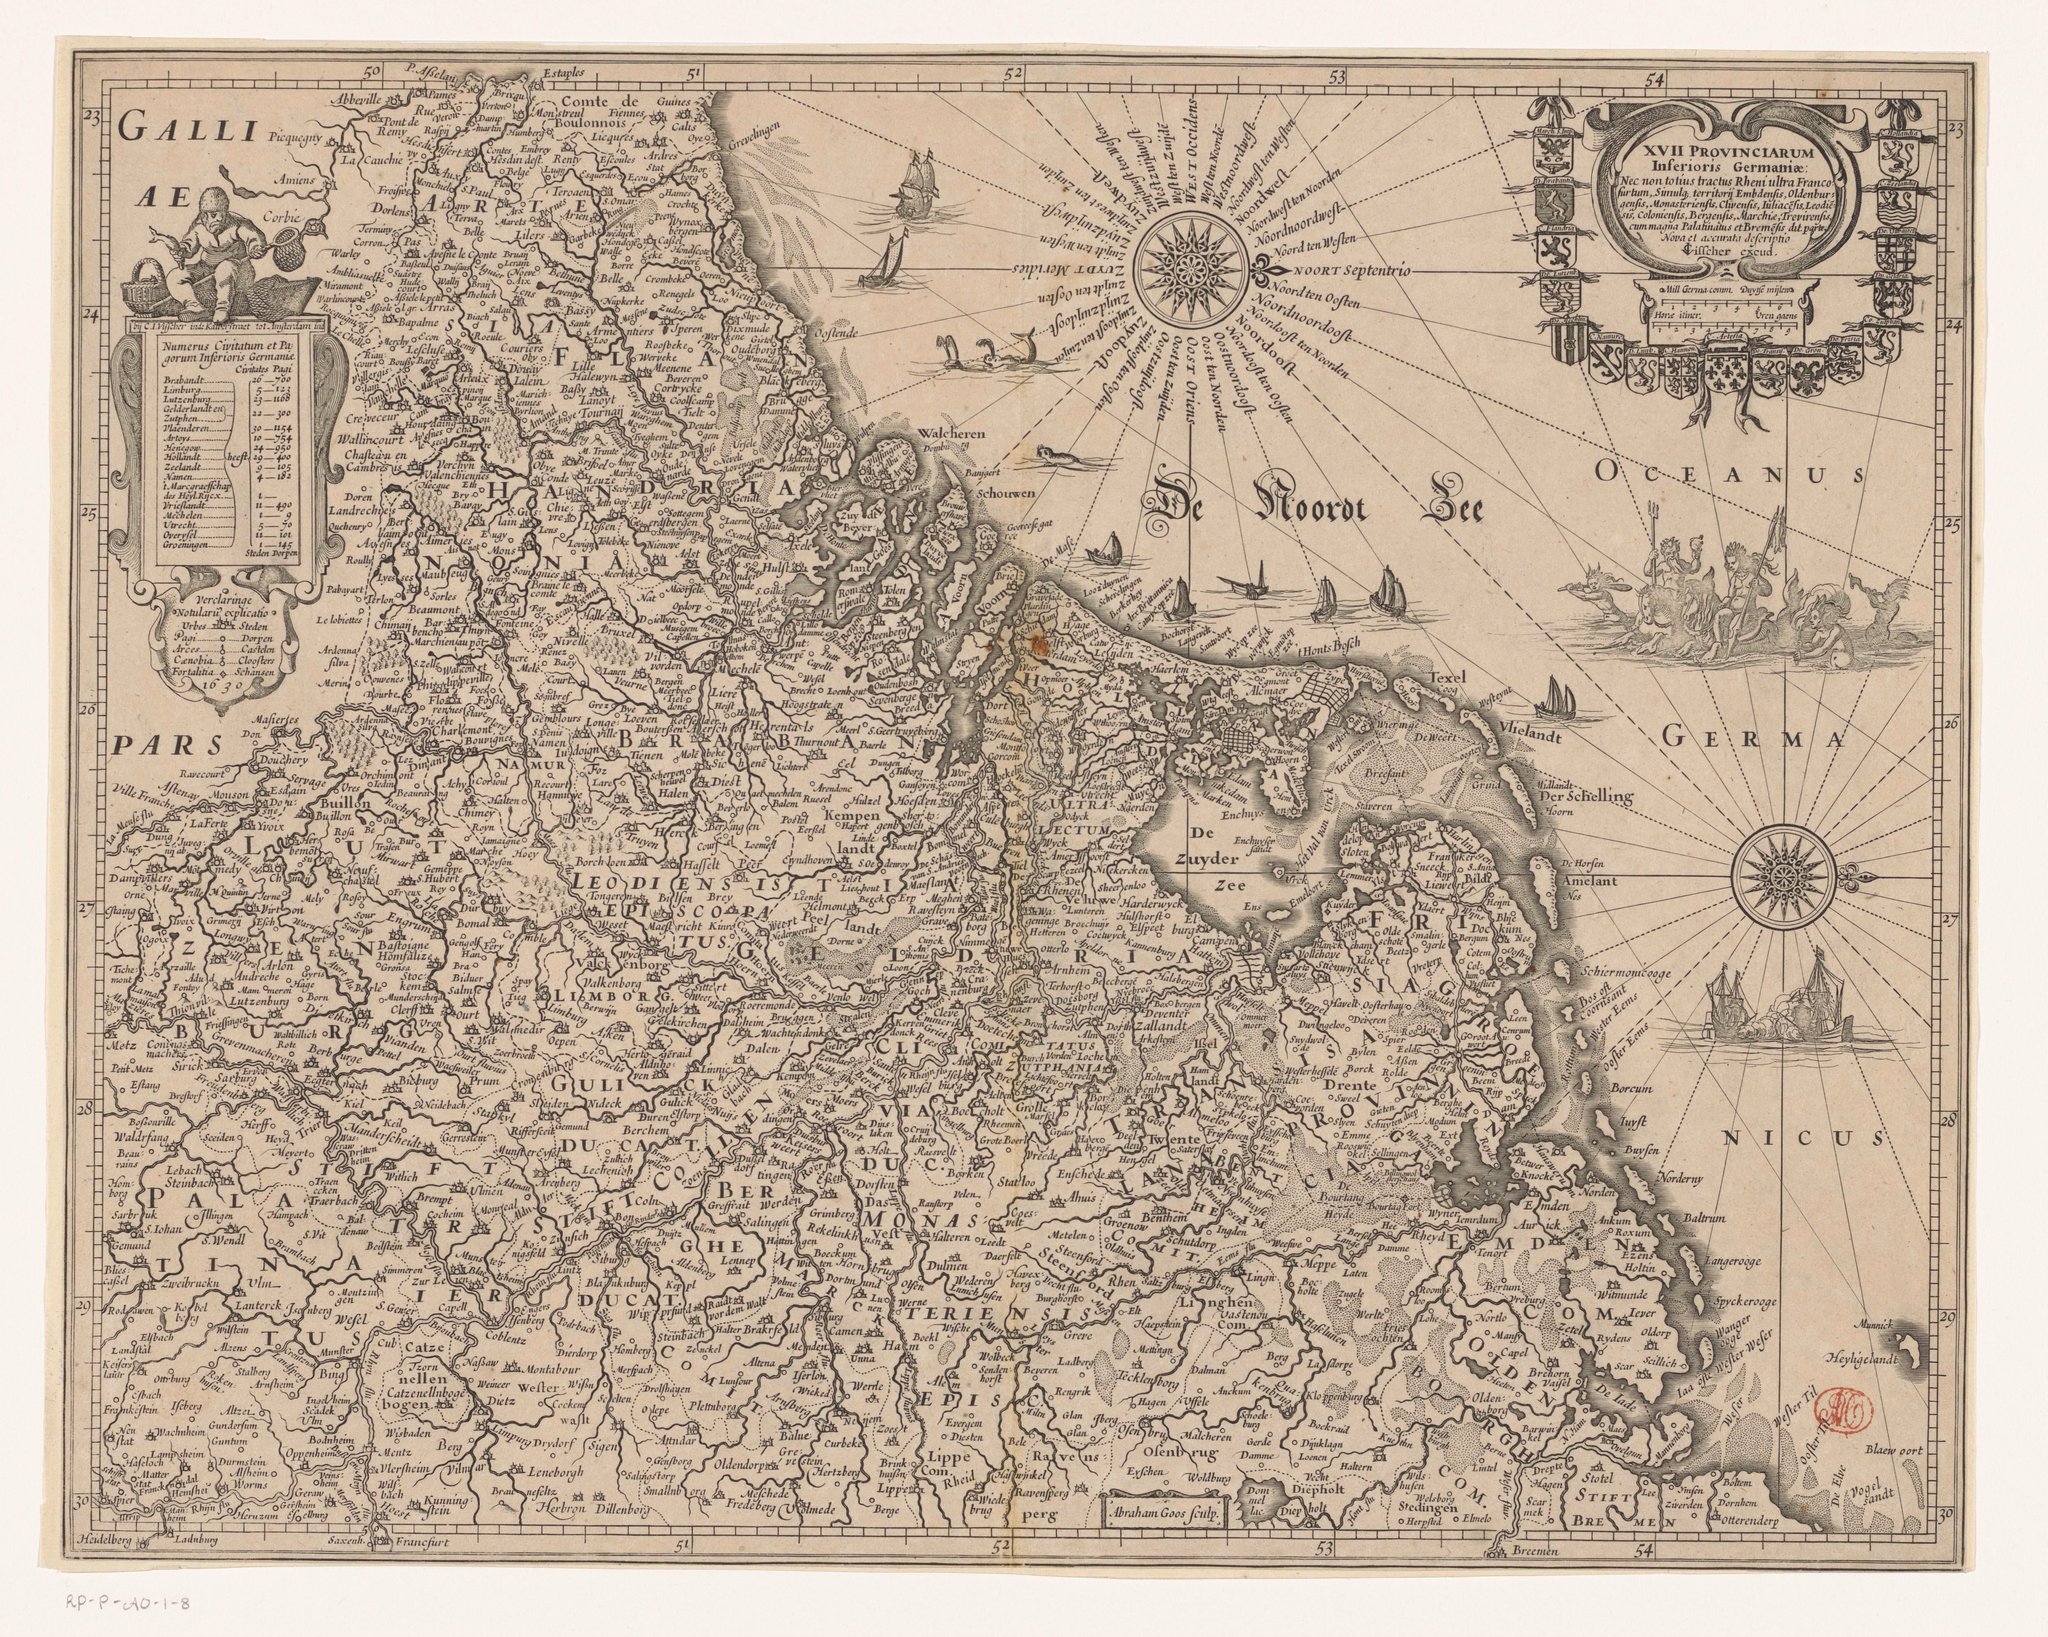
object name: print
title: Kaart van de Zeventien Provinciën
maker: abraham goos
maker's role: print maker, publisher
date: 1630-1645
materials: paper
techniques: engraving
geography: amsterdam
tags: (story of) neptune (poseidon), maps of separate countries or regions, coat of arms (as symbol of the state, etc.) (+ province; provincial), fisherman, low countries, belgium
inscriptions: collector's mark: Lugt 2228, collector's mark: Lugt 195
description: Kaart van de Zeventien Provinciën. Rechtsboven de titelcartouche met daaromheen de provinciewapens. Links een cartouche met legenda en informatie over het aantal steden in iedere provincie, daarbovenop een visser. In de zee vissersboten, zeilschepen en een voorstelling met Neptunus. De kaart is voorzien van een gradenverdeling langs de randen.